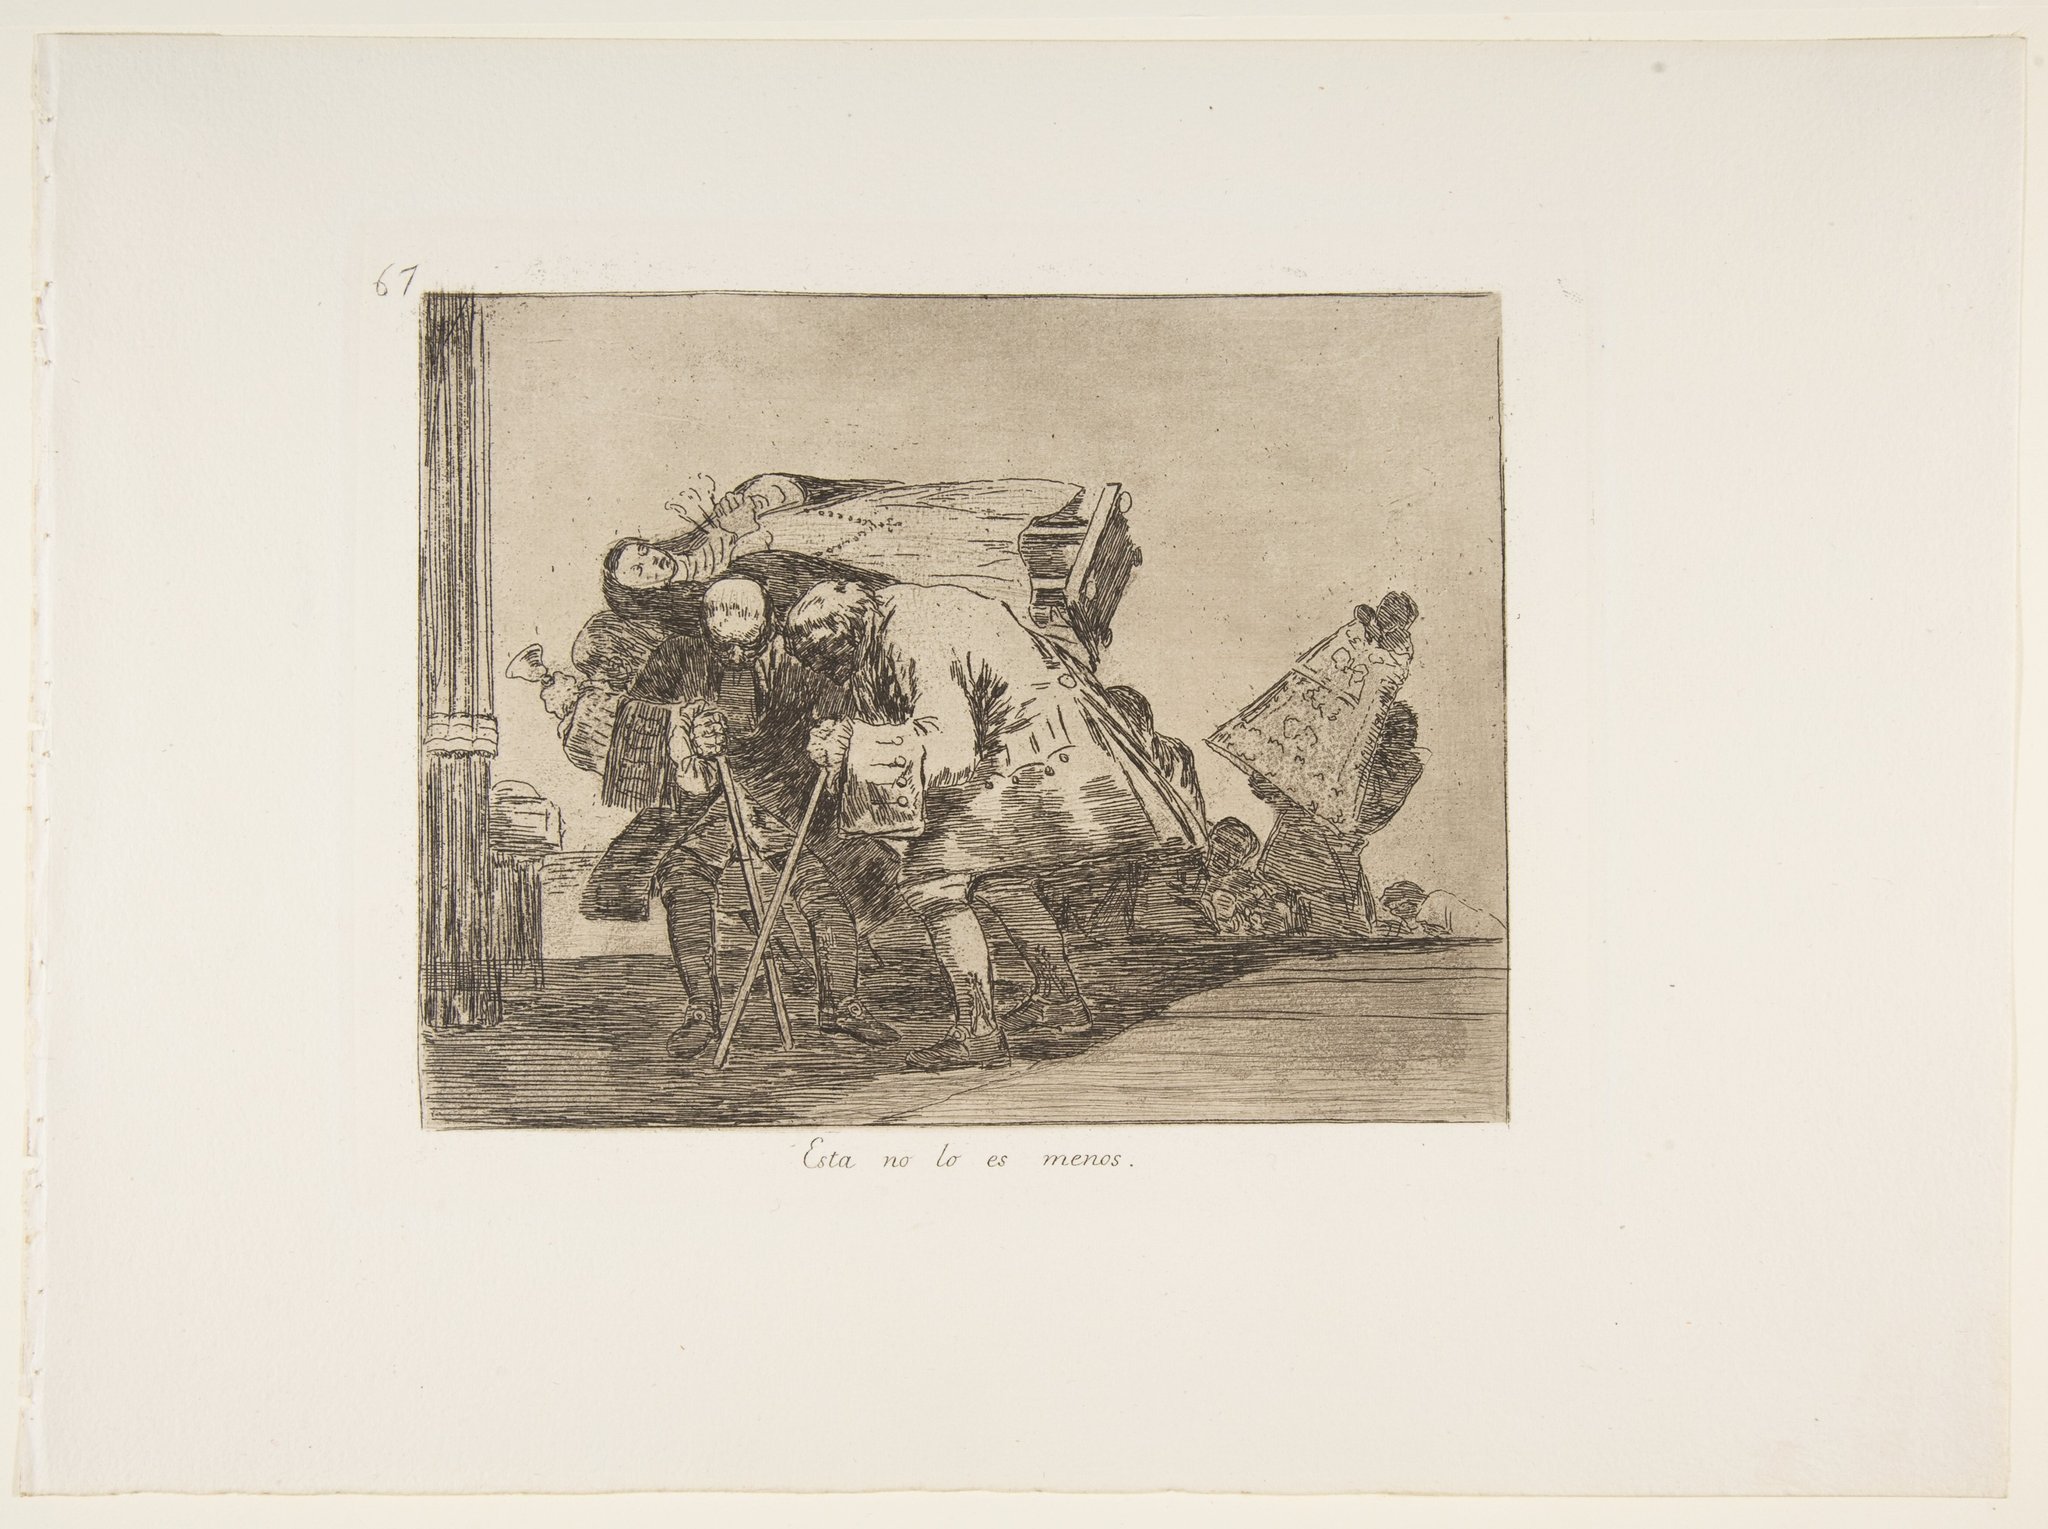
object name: print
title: Plate 67 from "The Disasters of War" (Los Desastres de la Guerra): 'This is not less so' (Esta no lo es menos)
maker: goya (francisco de goya y lucientes)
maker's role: artist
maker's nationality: spanish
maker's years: 1746-1828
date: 1814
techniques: aquatint, engraving, burnishing, drypoint, etching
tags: men,women